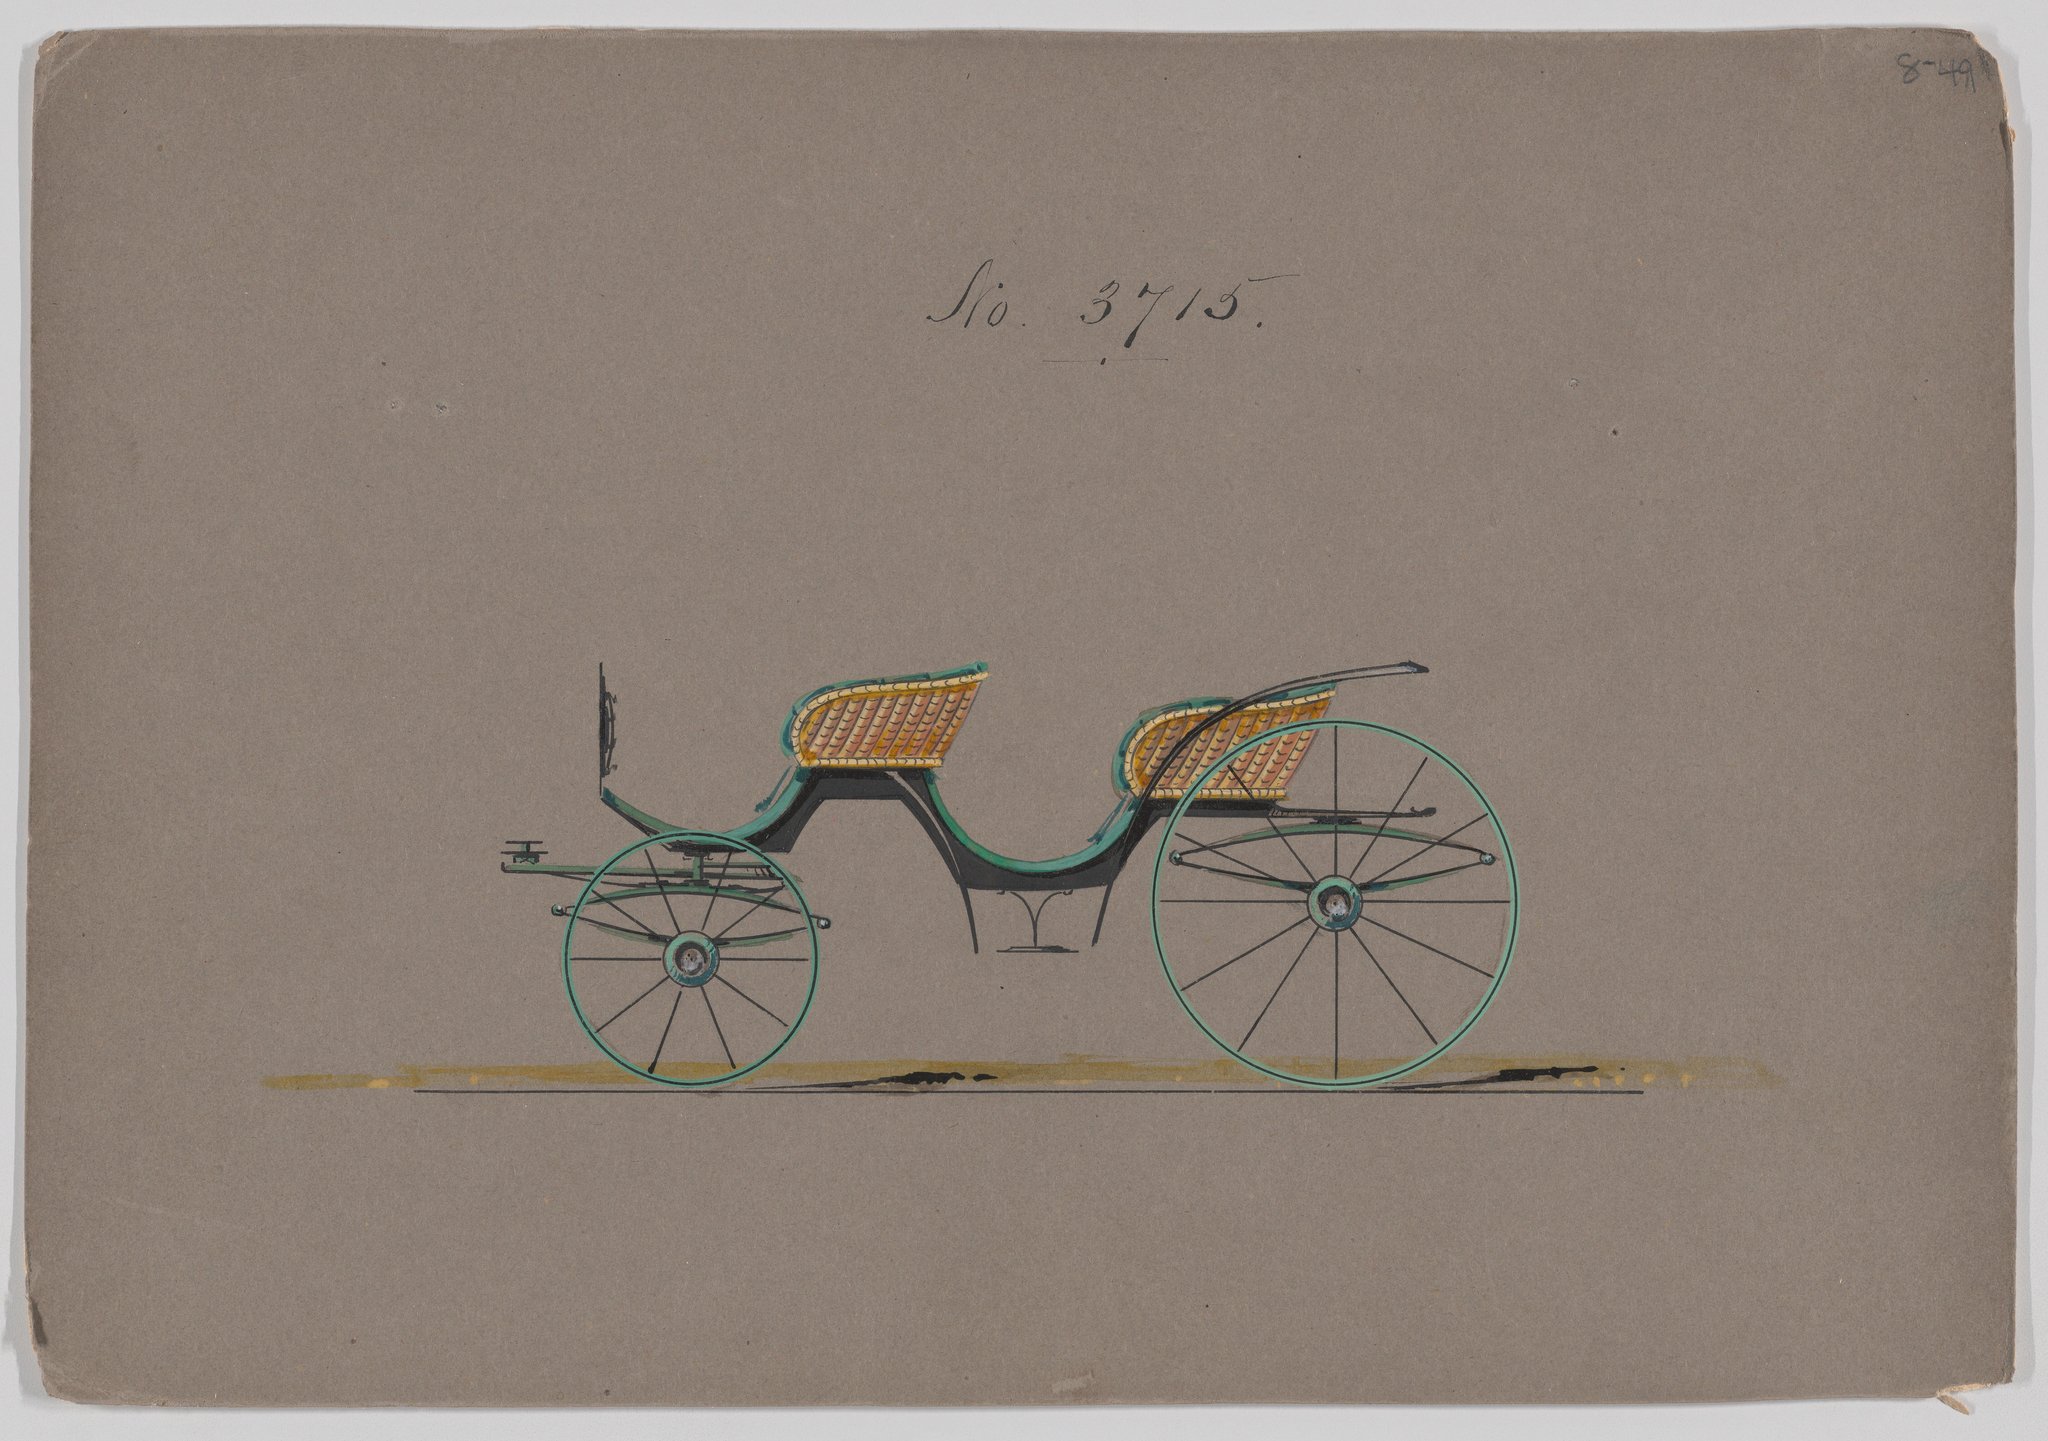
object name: drawing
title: Design for 4 seat Phaeton, no top, no. 3715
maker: brewster & co.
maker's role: manufacturer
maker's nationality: american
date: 1881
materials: gouache, ink, watercolor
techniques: pen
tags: carriages